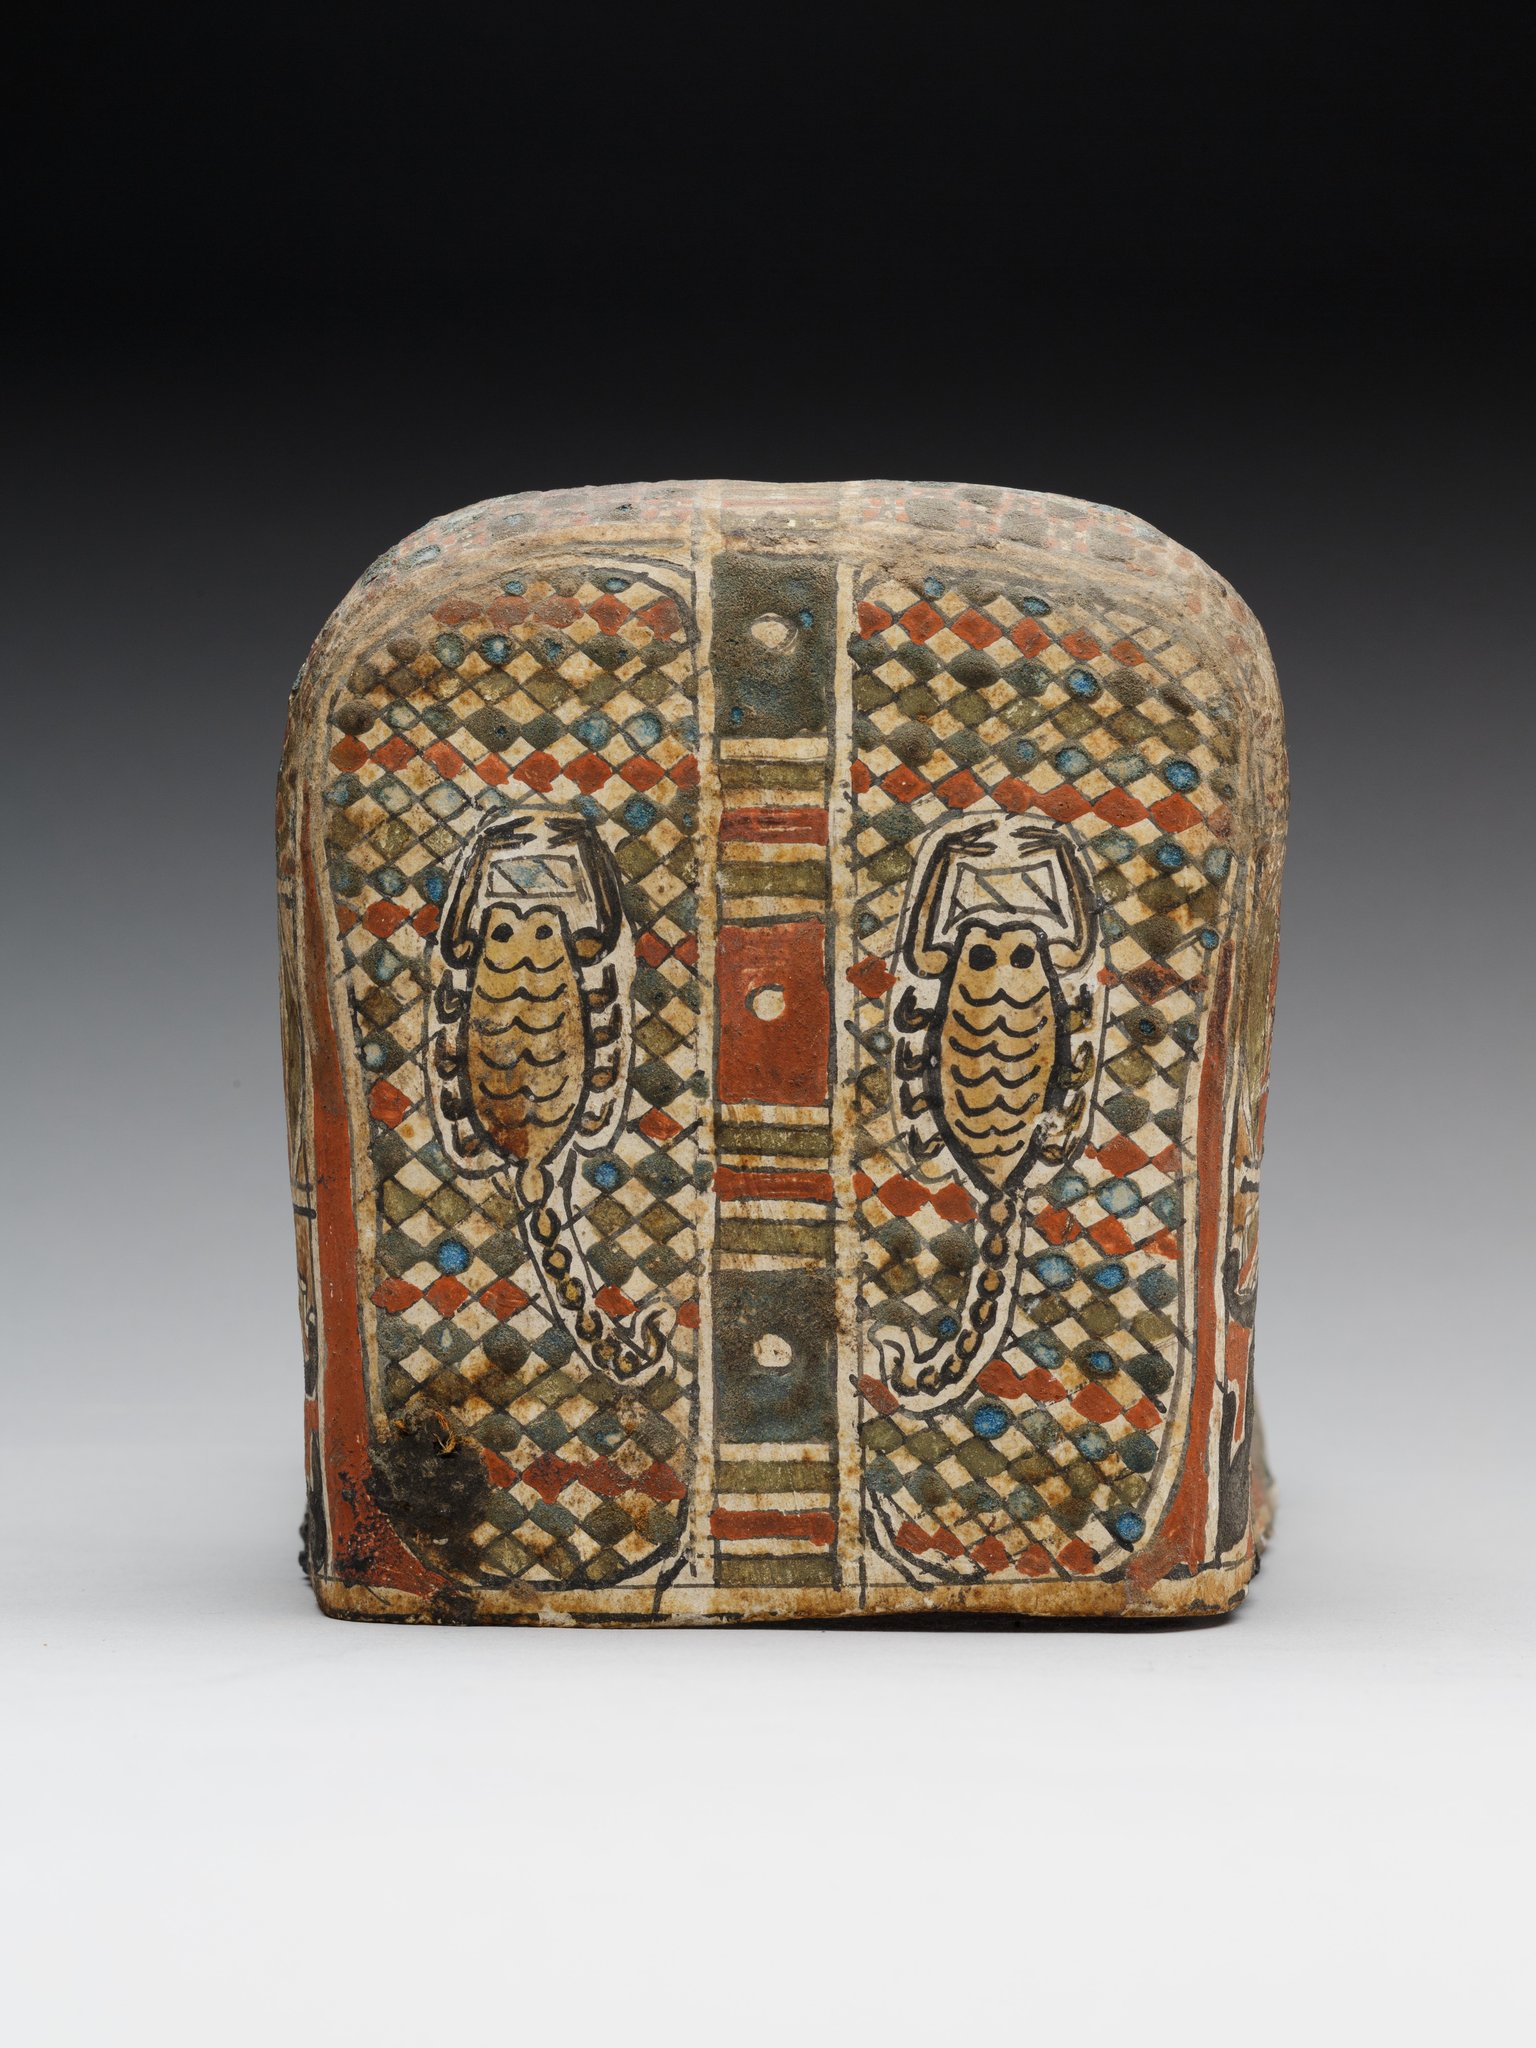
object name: coffin foot panel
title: Foot covering from a mummy, with scorpions on soles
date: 234 BCE-100 CE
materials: gesso, paint, wood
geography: egypt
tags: scorpions